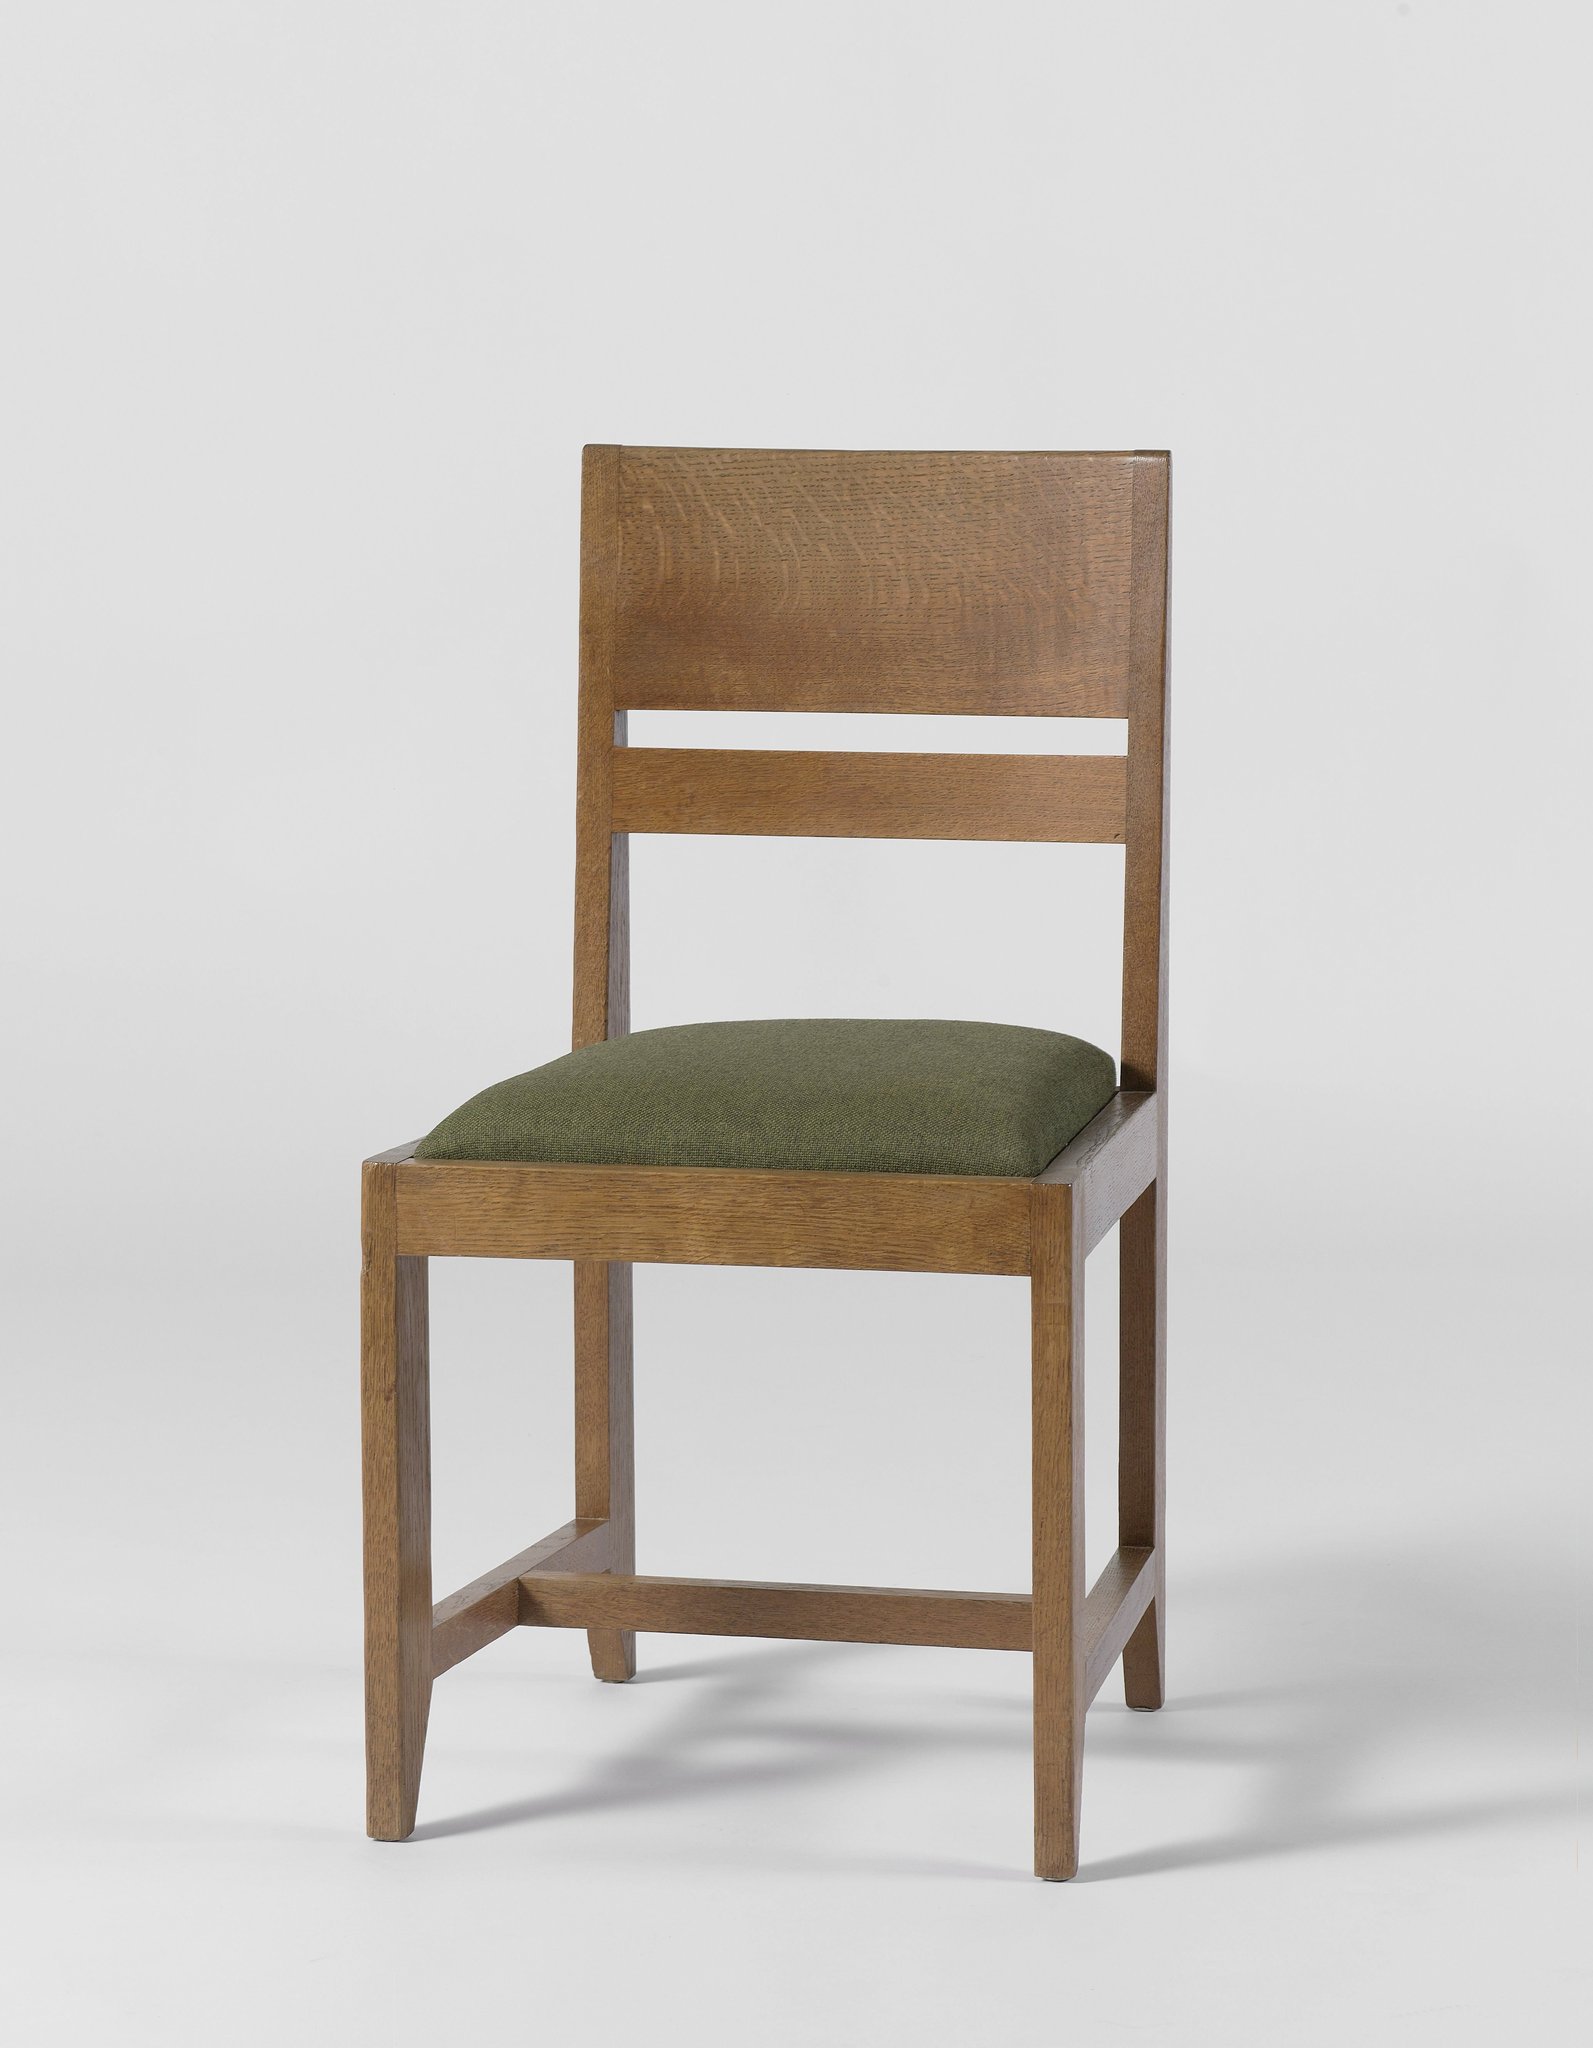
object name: chair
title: Stoel bekleed met groene wol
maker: hendrik wouda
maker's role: furniture worker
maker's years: 1885-1946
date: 1924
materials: wood, wool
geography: the hague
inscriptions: plate: ‘H. PANDER & ZONEN, DEN HAAG, AMSTERDAM, ROTTERDAM’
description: Stoel van eikenhout rustend op vier poten. De poten zijn onderling verbonden door middel van een H-vormig kruis. De voorpoten hebben zowel aan de onder- als bovenkant een afgeschuinde zijde. De achterpoten lopen door in de naar boven toelopende rugstijlen. De rugleuning bestaat uit een brede bovendorpel met daaronder een smalle regel. Daartussen en daaronder bevindt zich een open ruimte. De losse zitting rust op vier regels die de poten aan de bovenzijde met elkaar verbinden. De zitting is bekleed met groene wol.